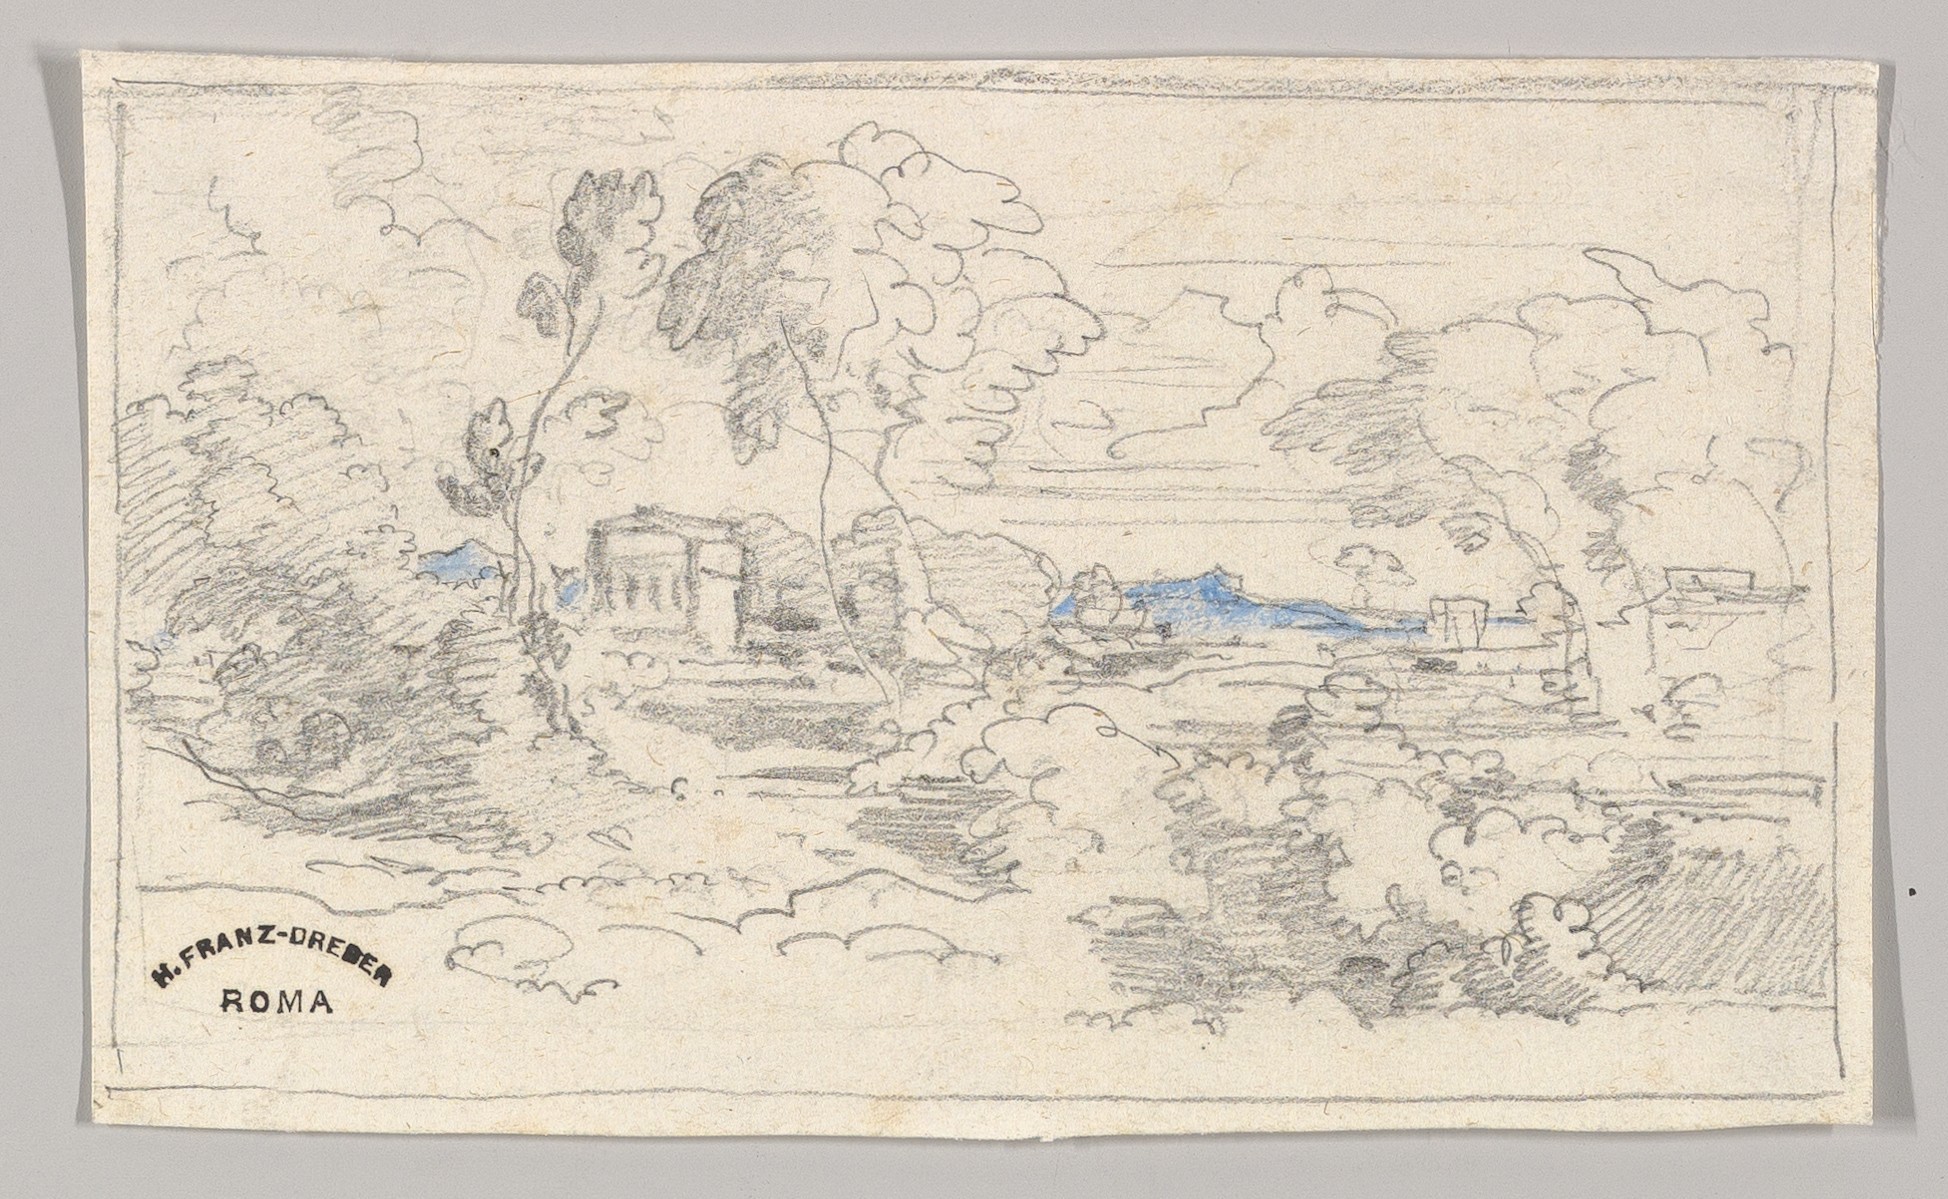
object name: drawing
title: Southern landscape with a building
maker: heinrich dreber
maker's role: artist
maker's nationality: german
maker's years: 1822-1875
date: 1855-1858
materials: graphite, watercolor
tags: buildings,landscapes,trees